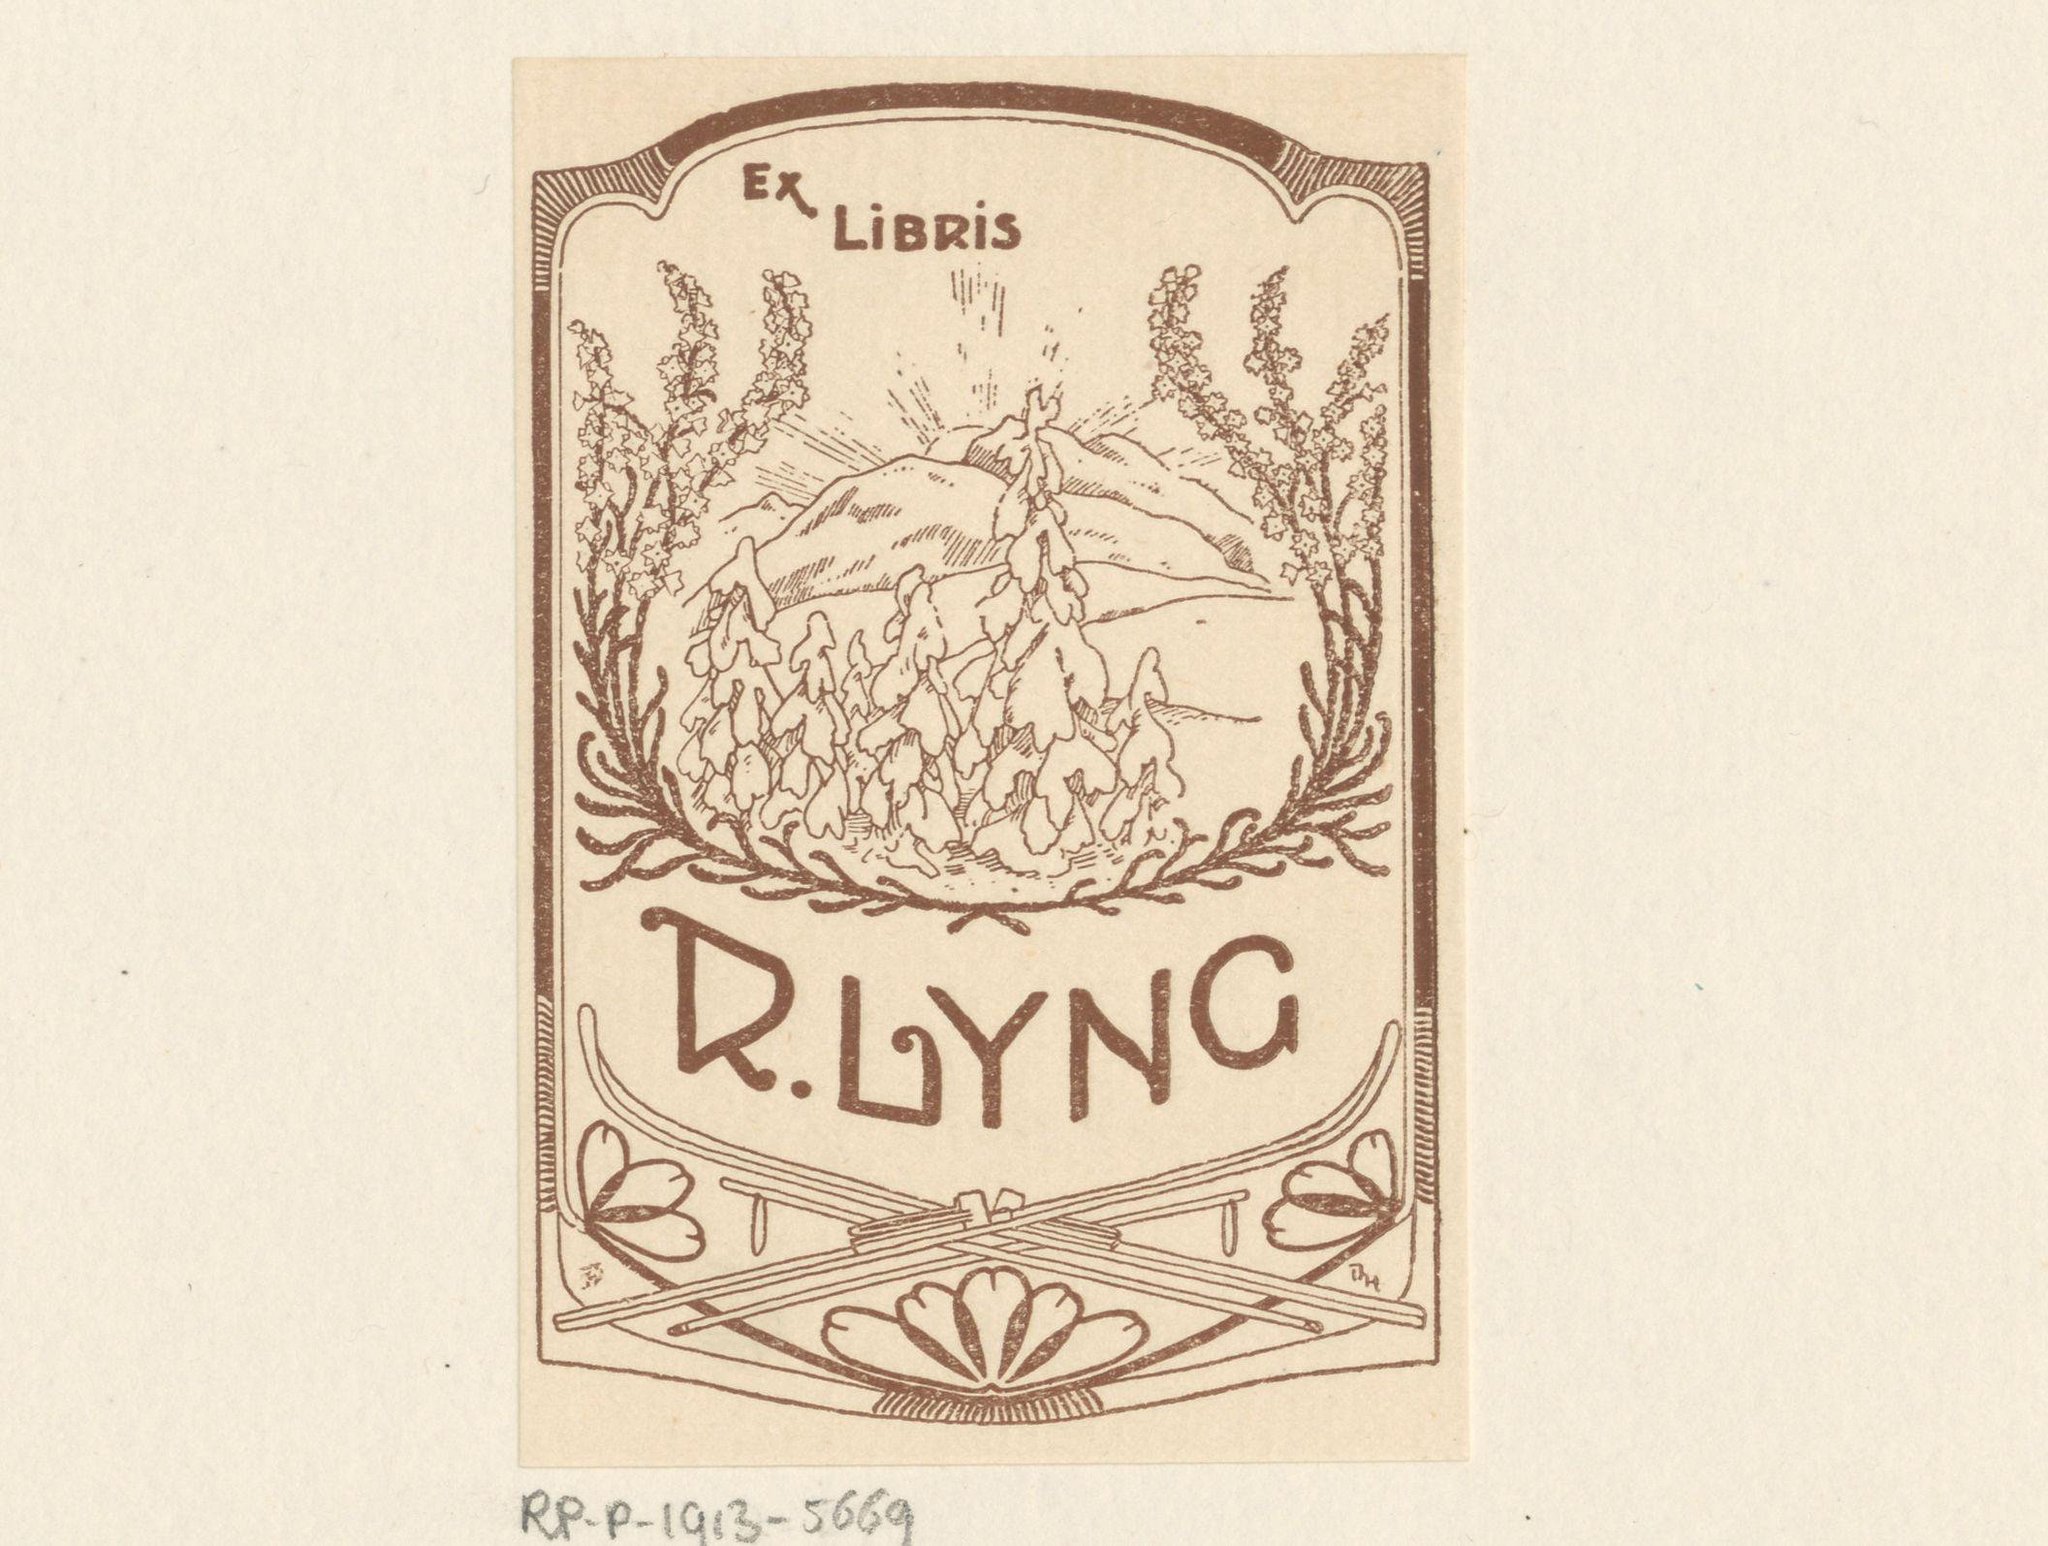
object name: bookplate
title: Ex libris van R. Lyng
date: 1906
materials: paper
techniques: printing block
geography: norway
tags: skis (winter sports), flowers, snow, sunset, mountains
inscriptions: inscription: ‘Kristiania’, collector's mark: Lugt 2233, collector's mark: Lugt 2760